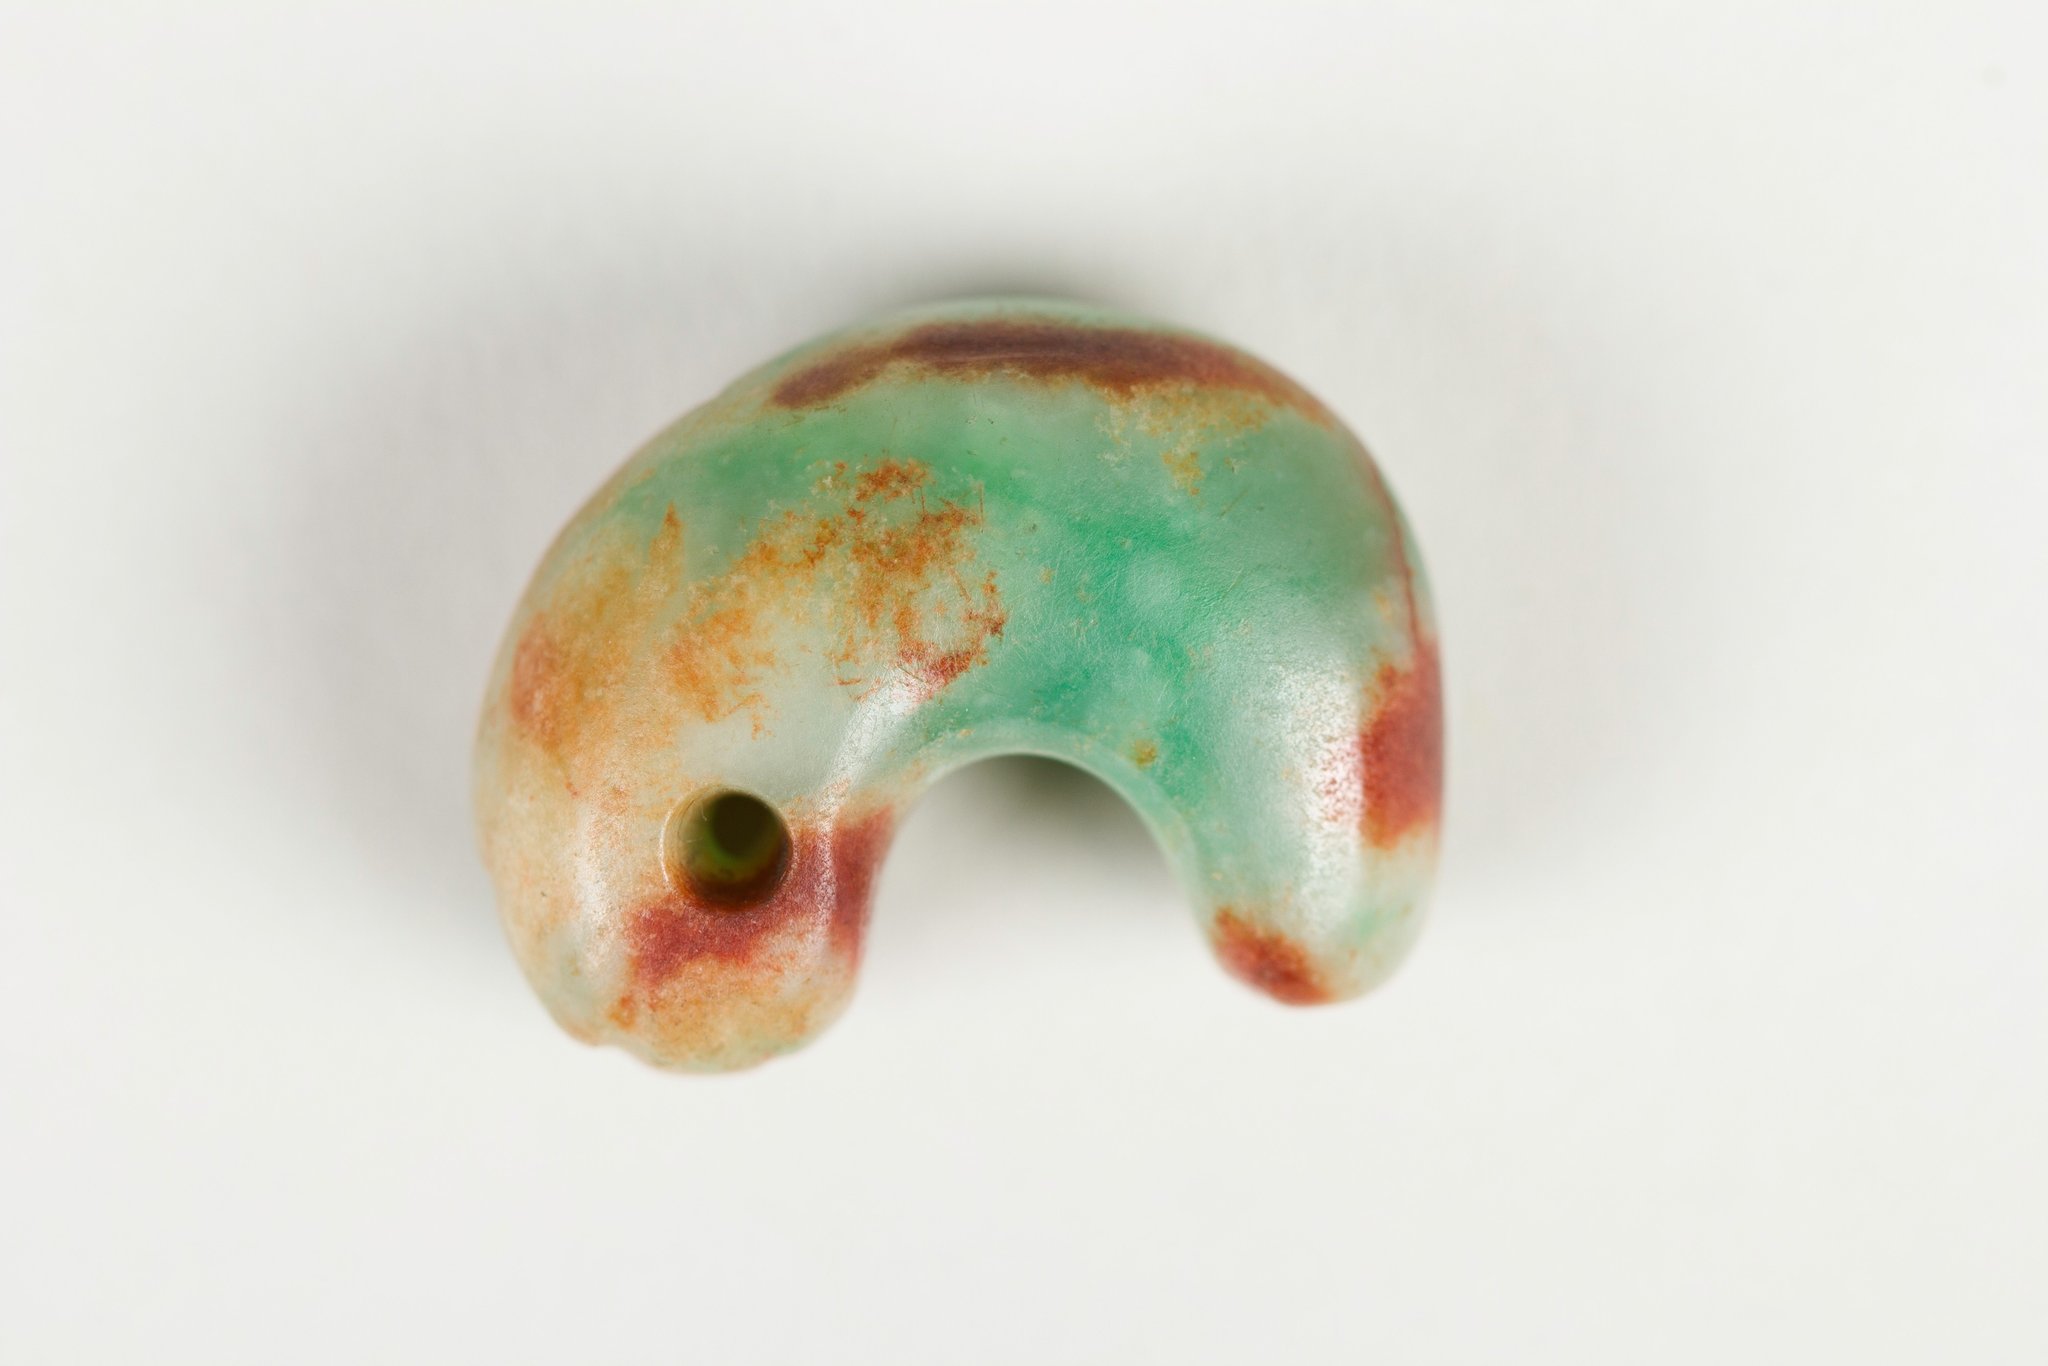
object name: bead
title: Carved Bead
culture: chinese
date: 1902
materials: jade